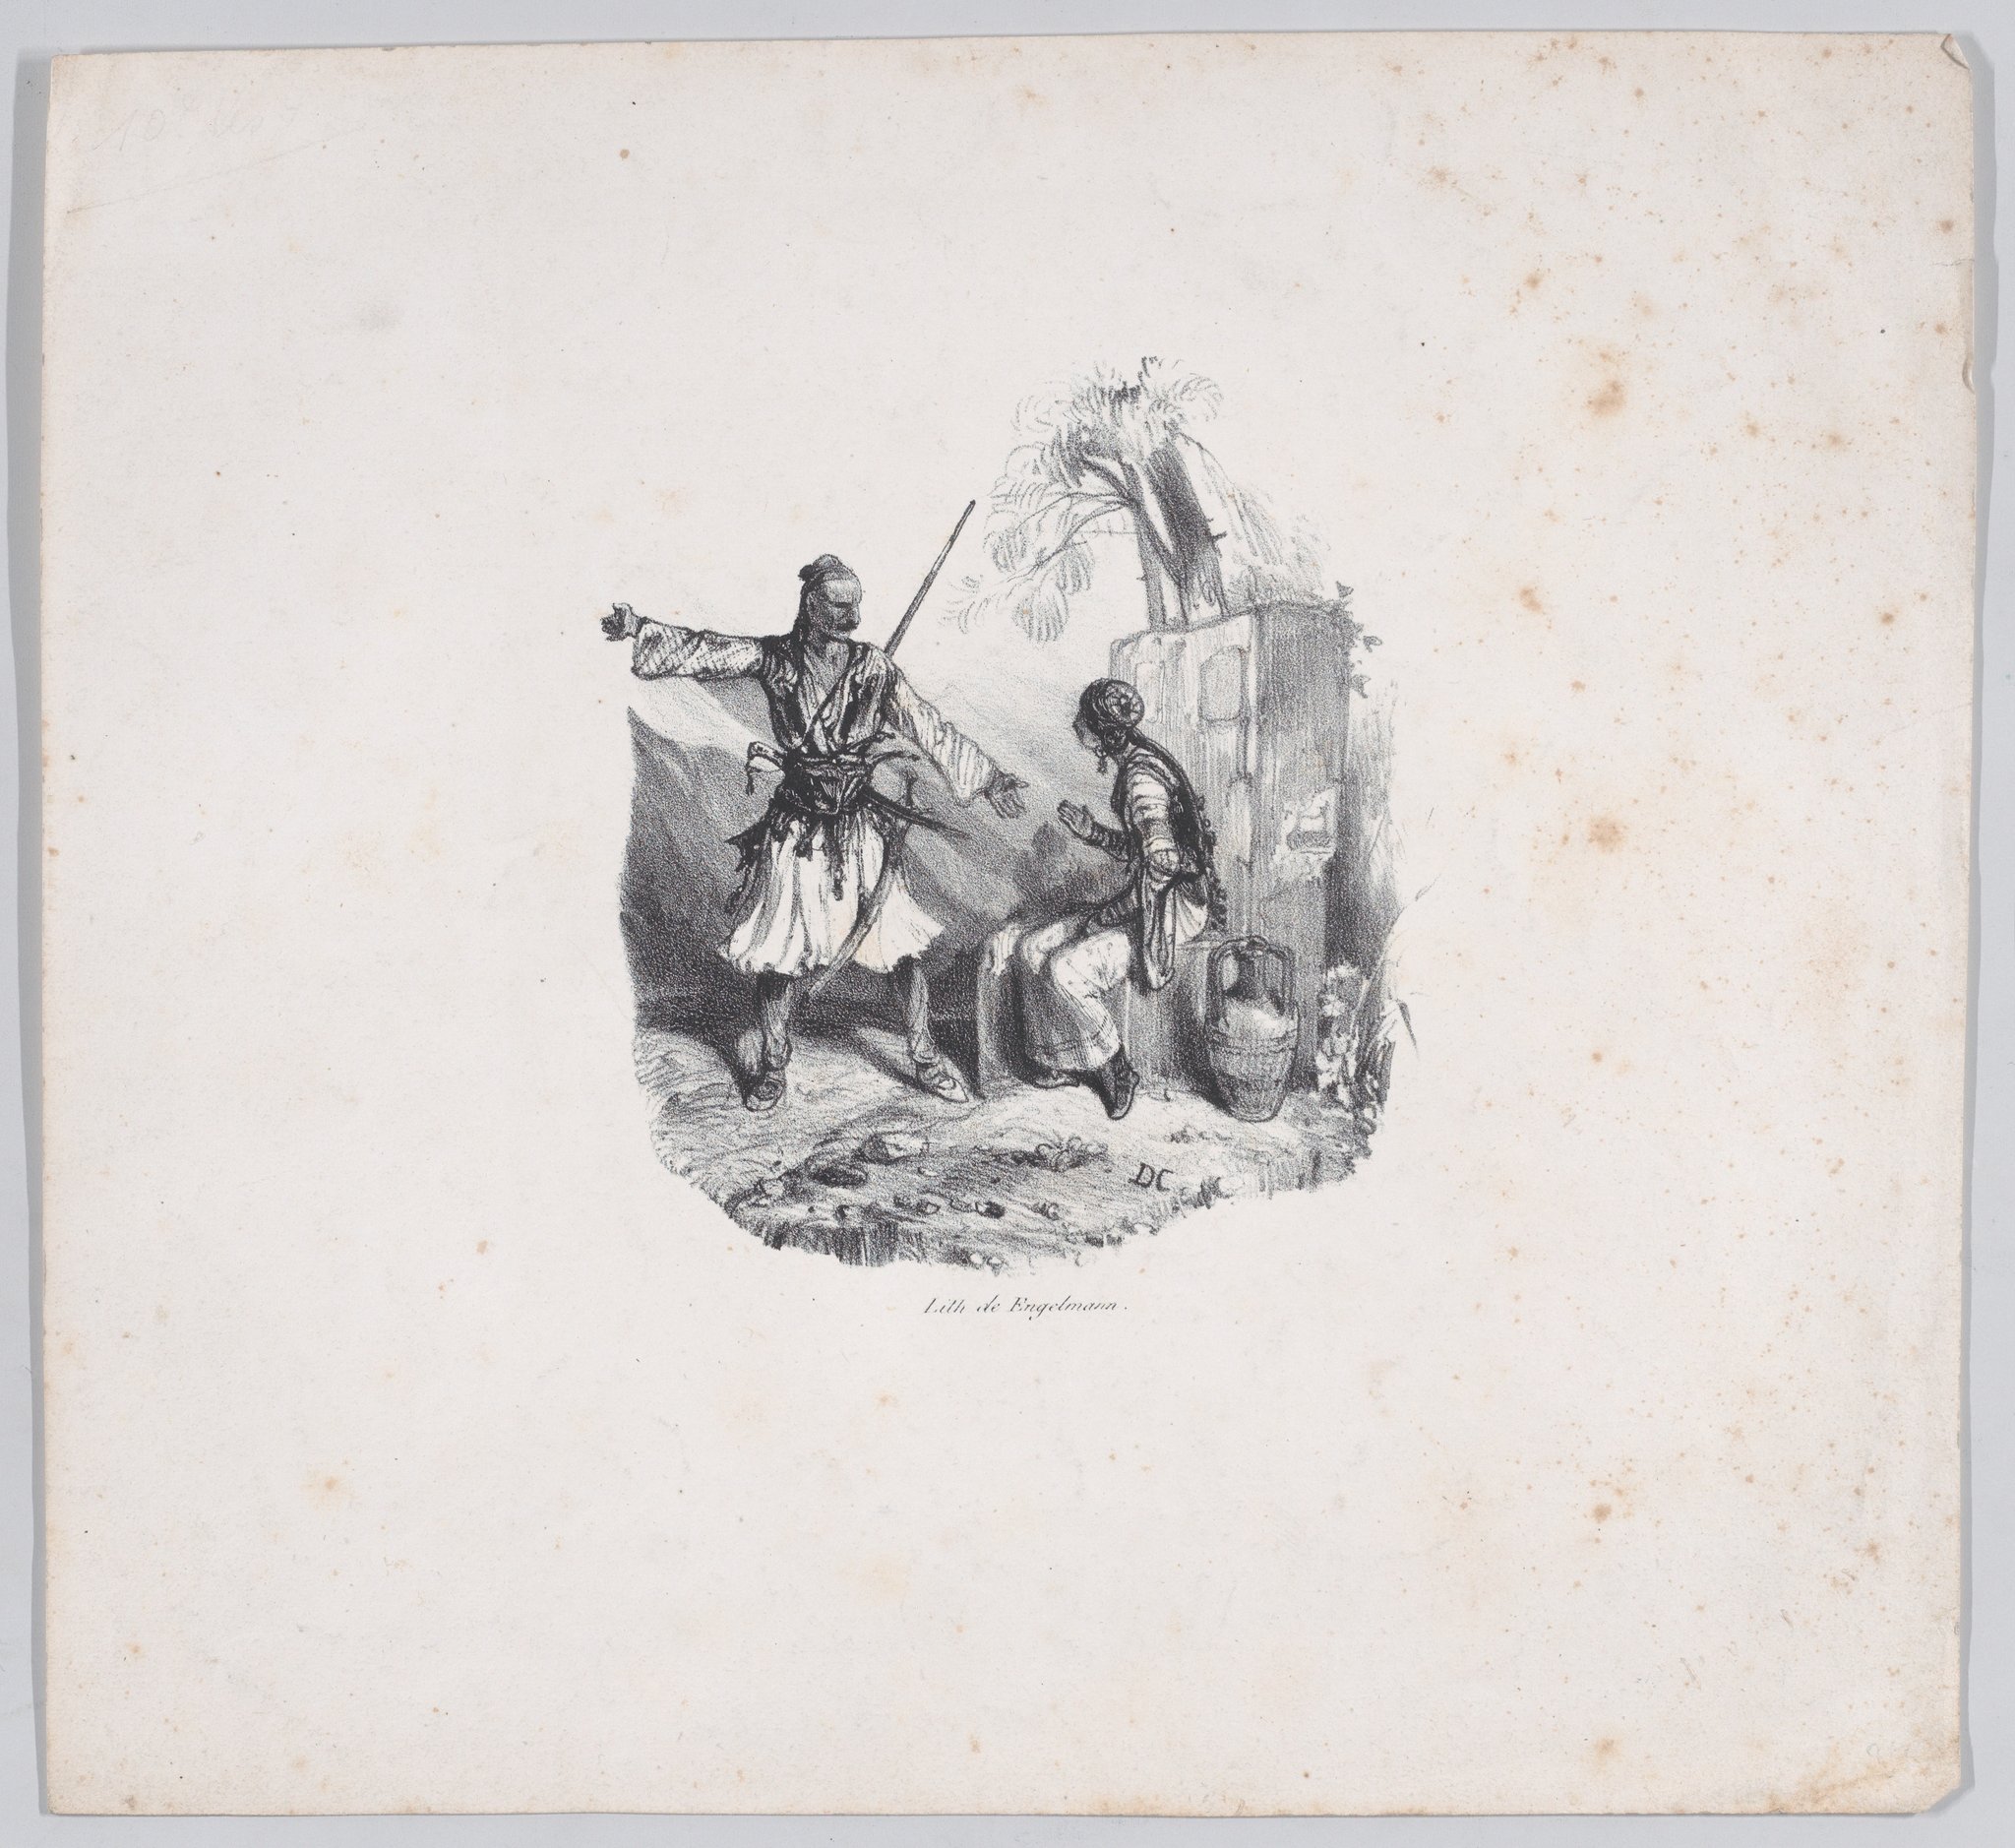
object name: print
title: The Klepht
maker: alexandre-gabriel decamps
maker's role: artist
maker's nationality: french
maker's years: 1803-1860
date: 1830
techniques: lithograph